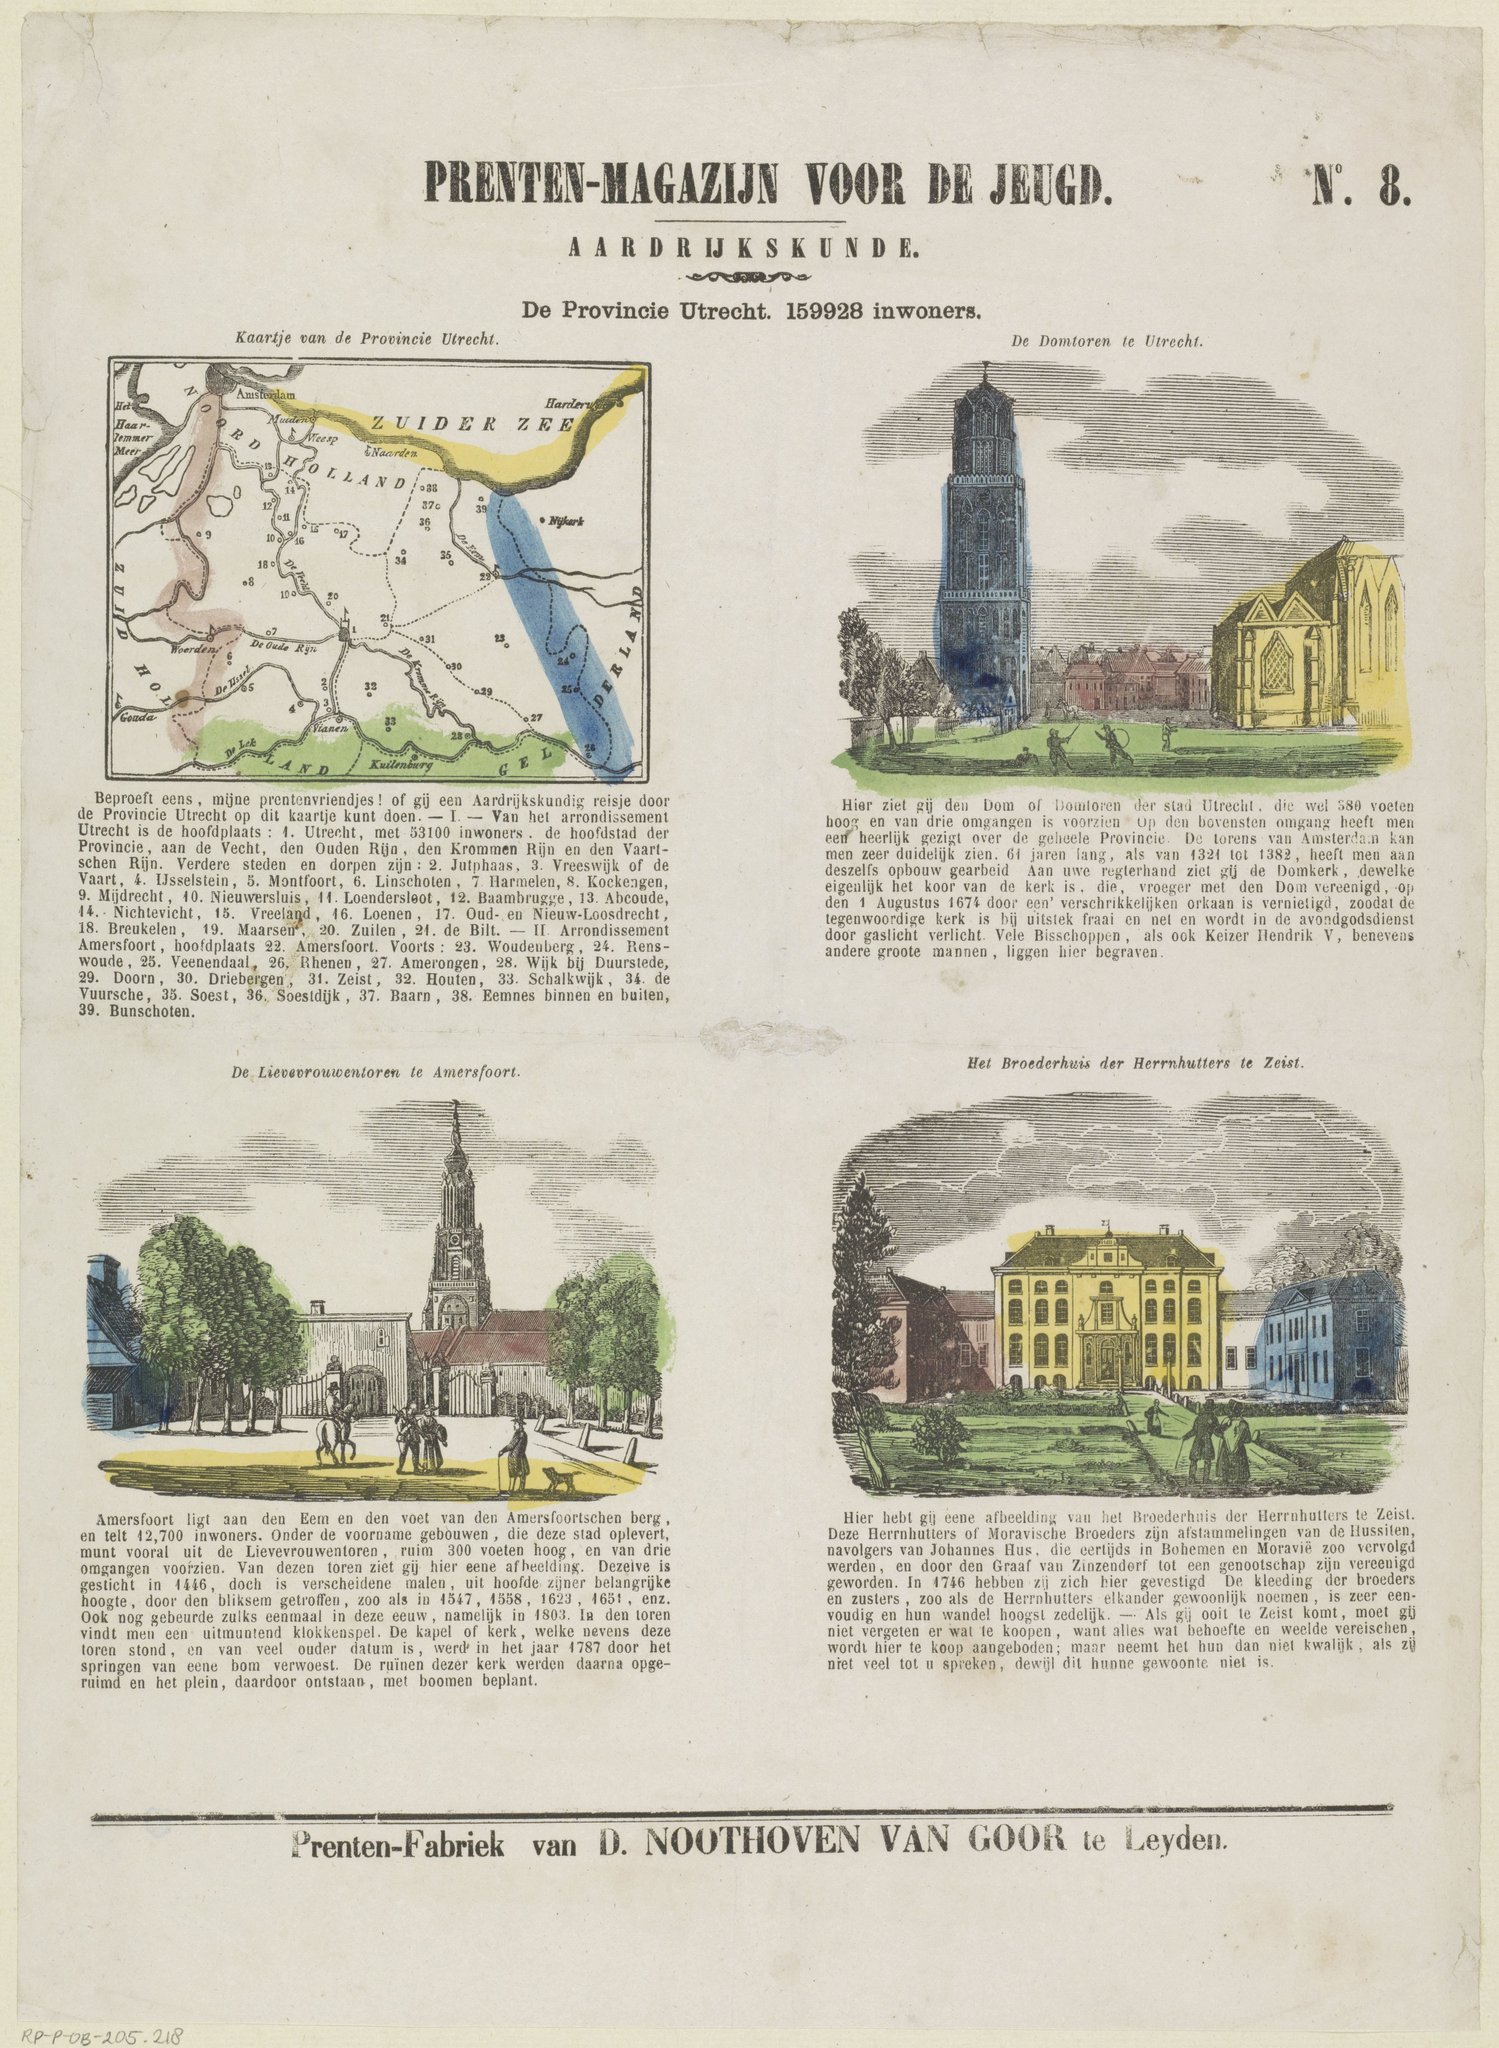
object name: popular print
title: De provincie Utrecht. 159928 inwoners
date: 1850-1881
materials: paper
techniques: colour, letterpress printing, engraving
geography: leiden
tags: maps, atlases, utrecht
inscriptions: collector's mark: Lugt 2760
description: Blad met 4 voorstellingen over de provincie Utrecht met een kaart en belangrijke gebouwen: de Domtoren in Utrecht, de Onze-Lieve-Vrouwetoren in Amersfoort en Slot Zeist te Zeist. Boven elke voorstelling een titel en onder elke voorstelling een onderschrift. Genummerd rechtsboven: No. 8.